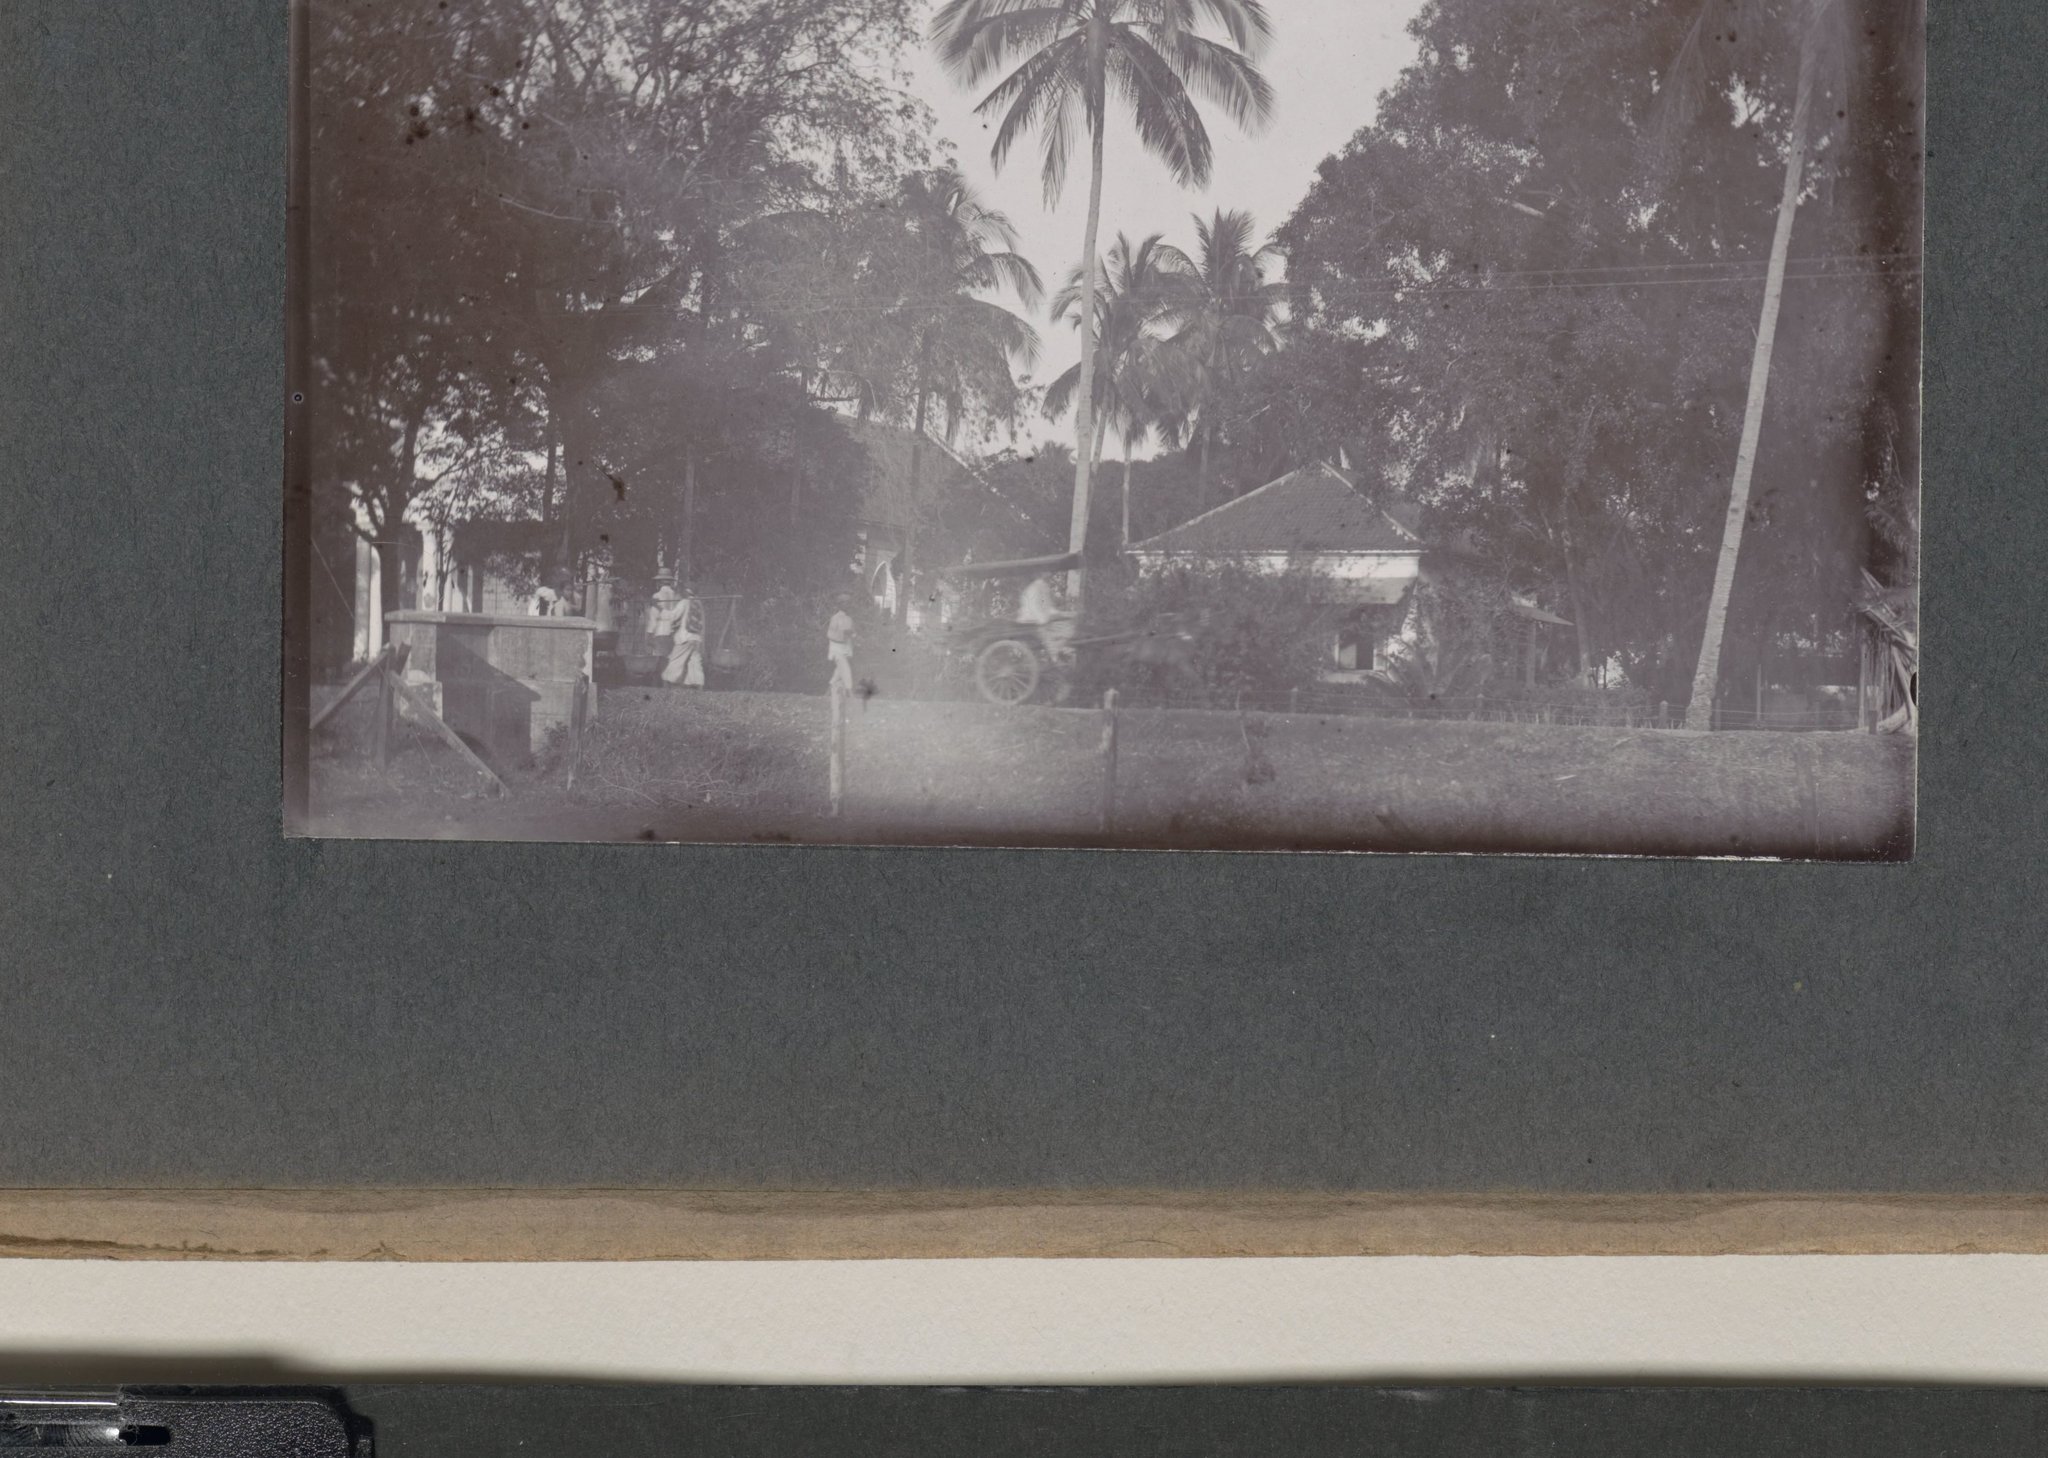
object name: photograph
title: Voorbijgangers en een ossenkar op een weg, vermoedelijk op het terrein van een ziekenhuis in Nederlands-Indië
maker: Anonymous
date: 1920-1930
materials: photographic support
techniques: gelatin silver print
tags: two-wheeled, animal-drawn vehicle, hospital, walking, trees: palm-tree, nursing, tending the sick, dutch east indies, the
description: Onderdeel van fotoalbum van een ziekenhuis in Nederlands-Indië.